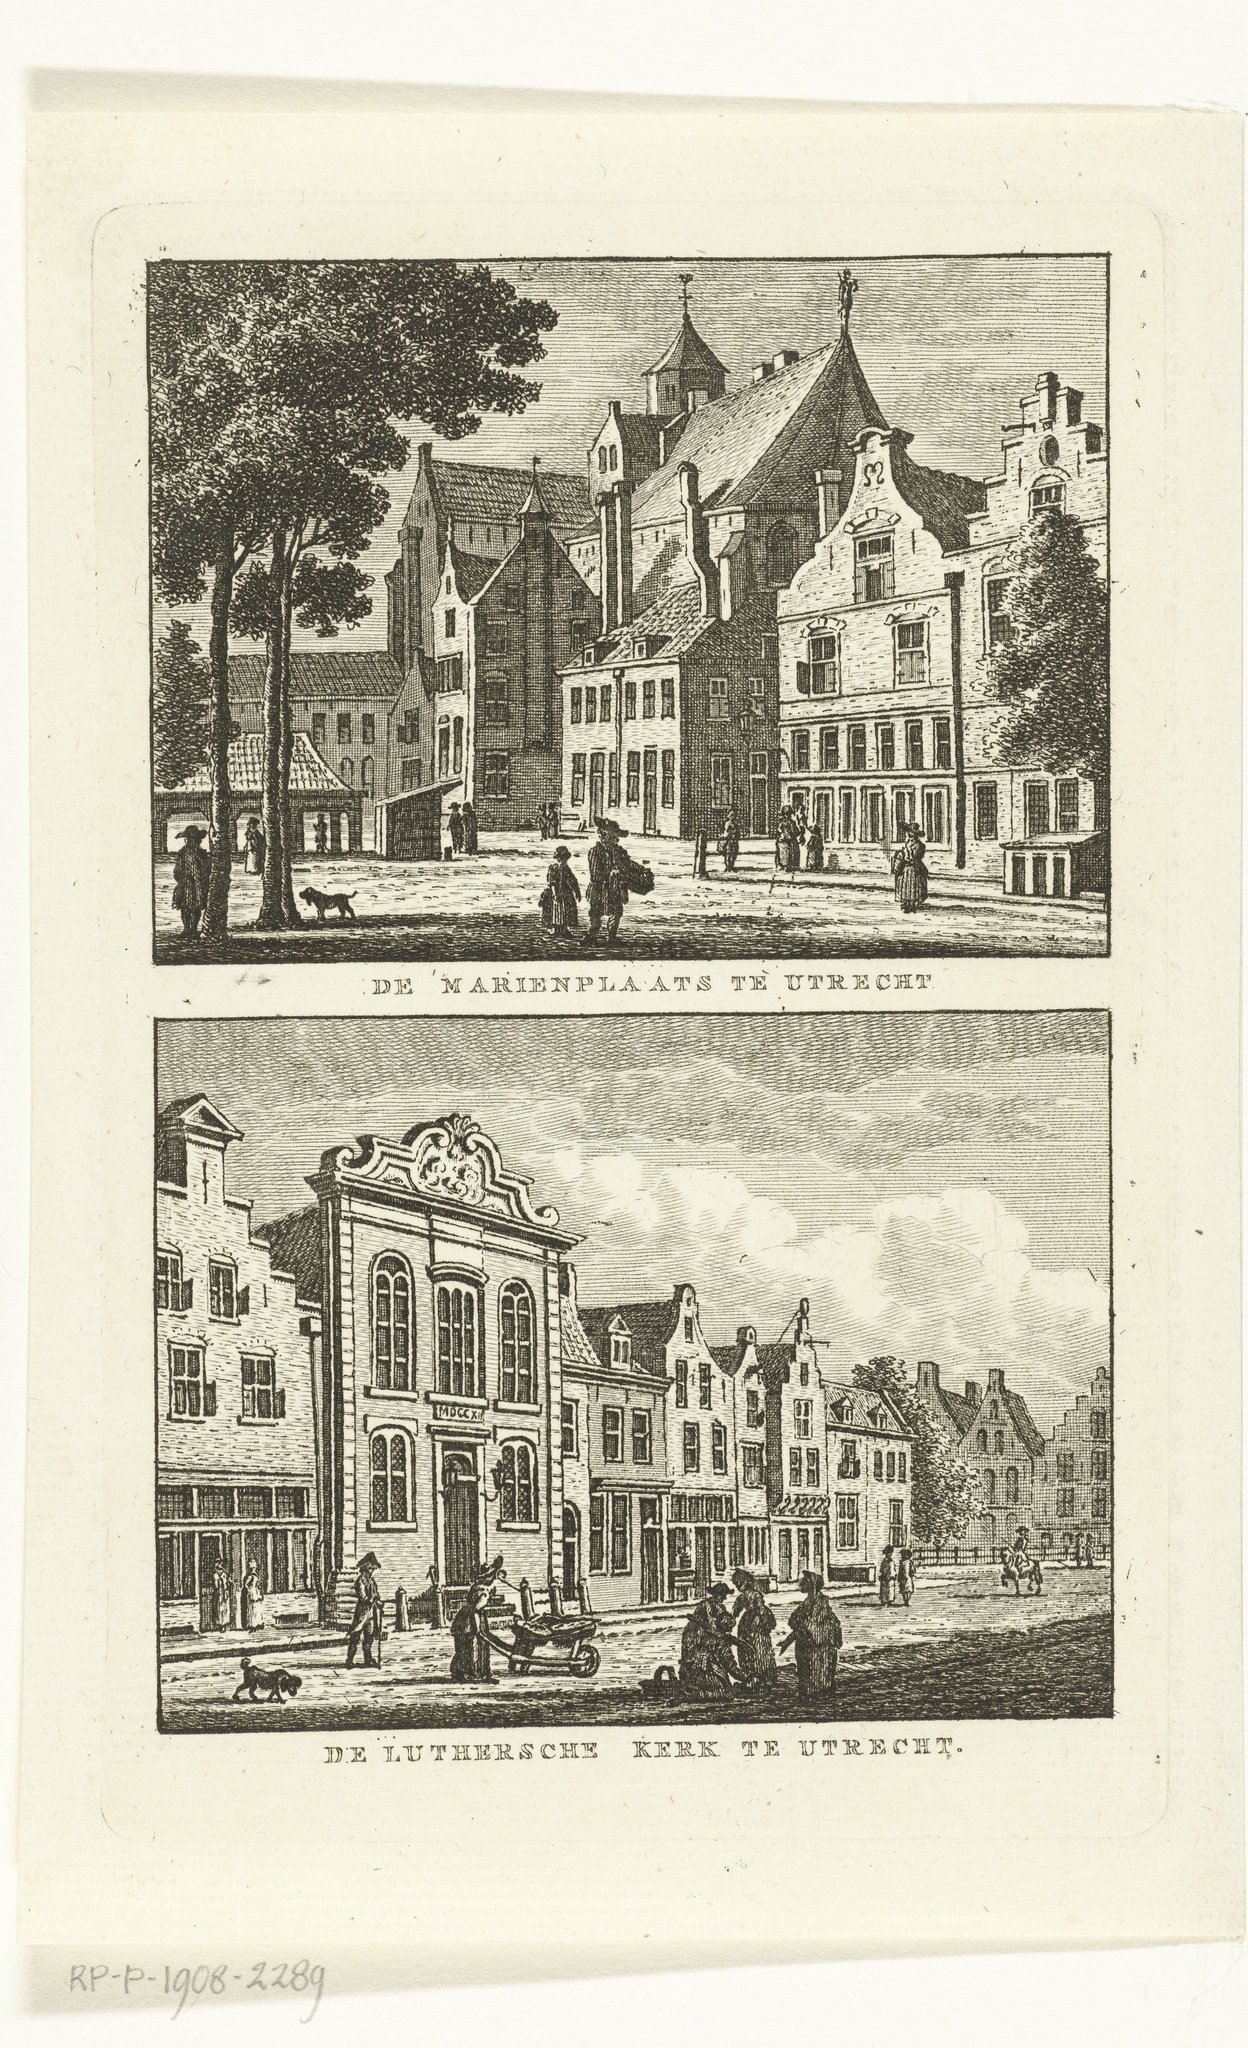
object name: print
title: De Marienplaats te Utrecht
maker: carel frederik bendorp (i)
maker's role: print maker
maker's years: 1736-1814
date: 1786-1792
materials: paper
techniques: etching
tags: city-view in general; 'veduta', church (exterior), utrecht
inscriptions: collector's mark: Lugt 2228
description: Prent uit: Vaderlandsche gezichten, of afbeeldingen van den tegenwoordigen staat der Vereenigde Nederlanden (…). Amsterdam: Hendrik Gartman, Willem Vermandel en Jan Willem Smit, 1786-1792. Uitgegeven in afleveringen met ieder een eigen bifolium en inhoudsopgave. Alle prenten in deze publicatie zijn gegraveerd door Carel Frederik Bendorp (I) en, in de meeste gevallen, gebaseerd op tekeningen van Jan Bulthuis.